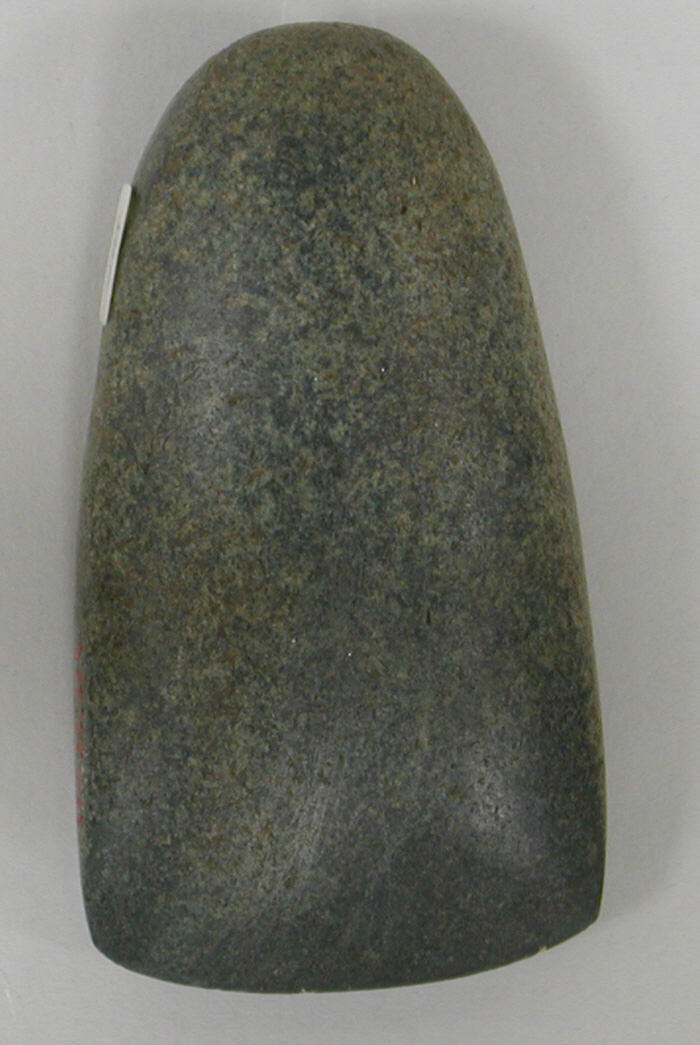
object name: celt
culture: maya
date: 1501-1600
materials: stone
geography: guatemala